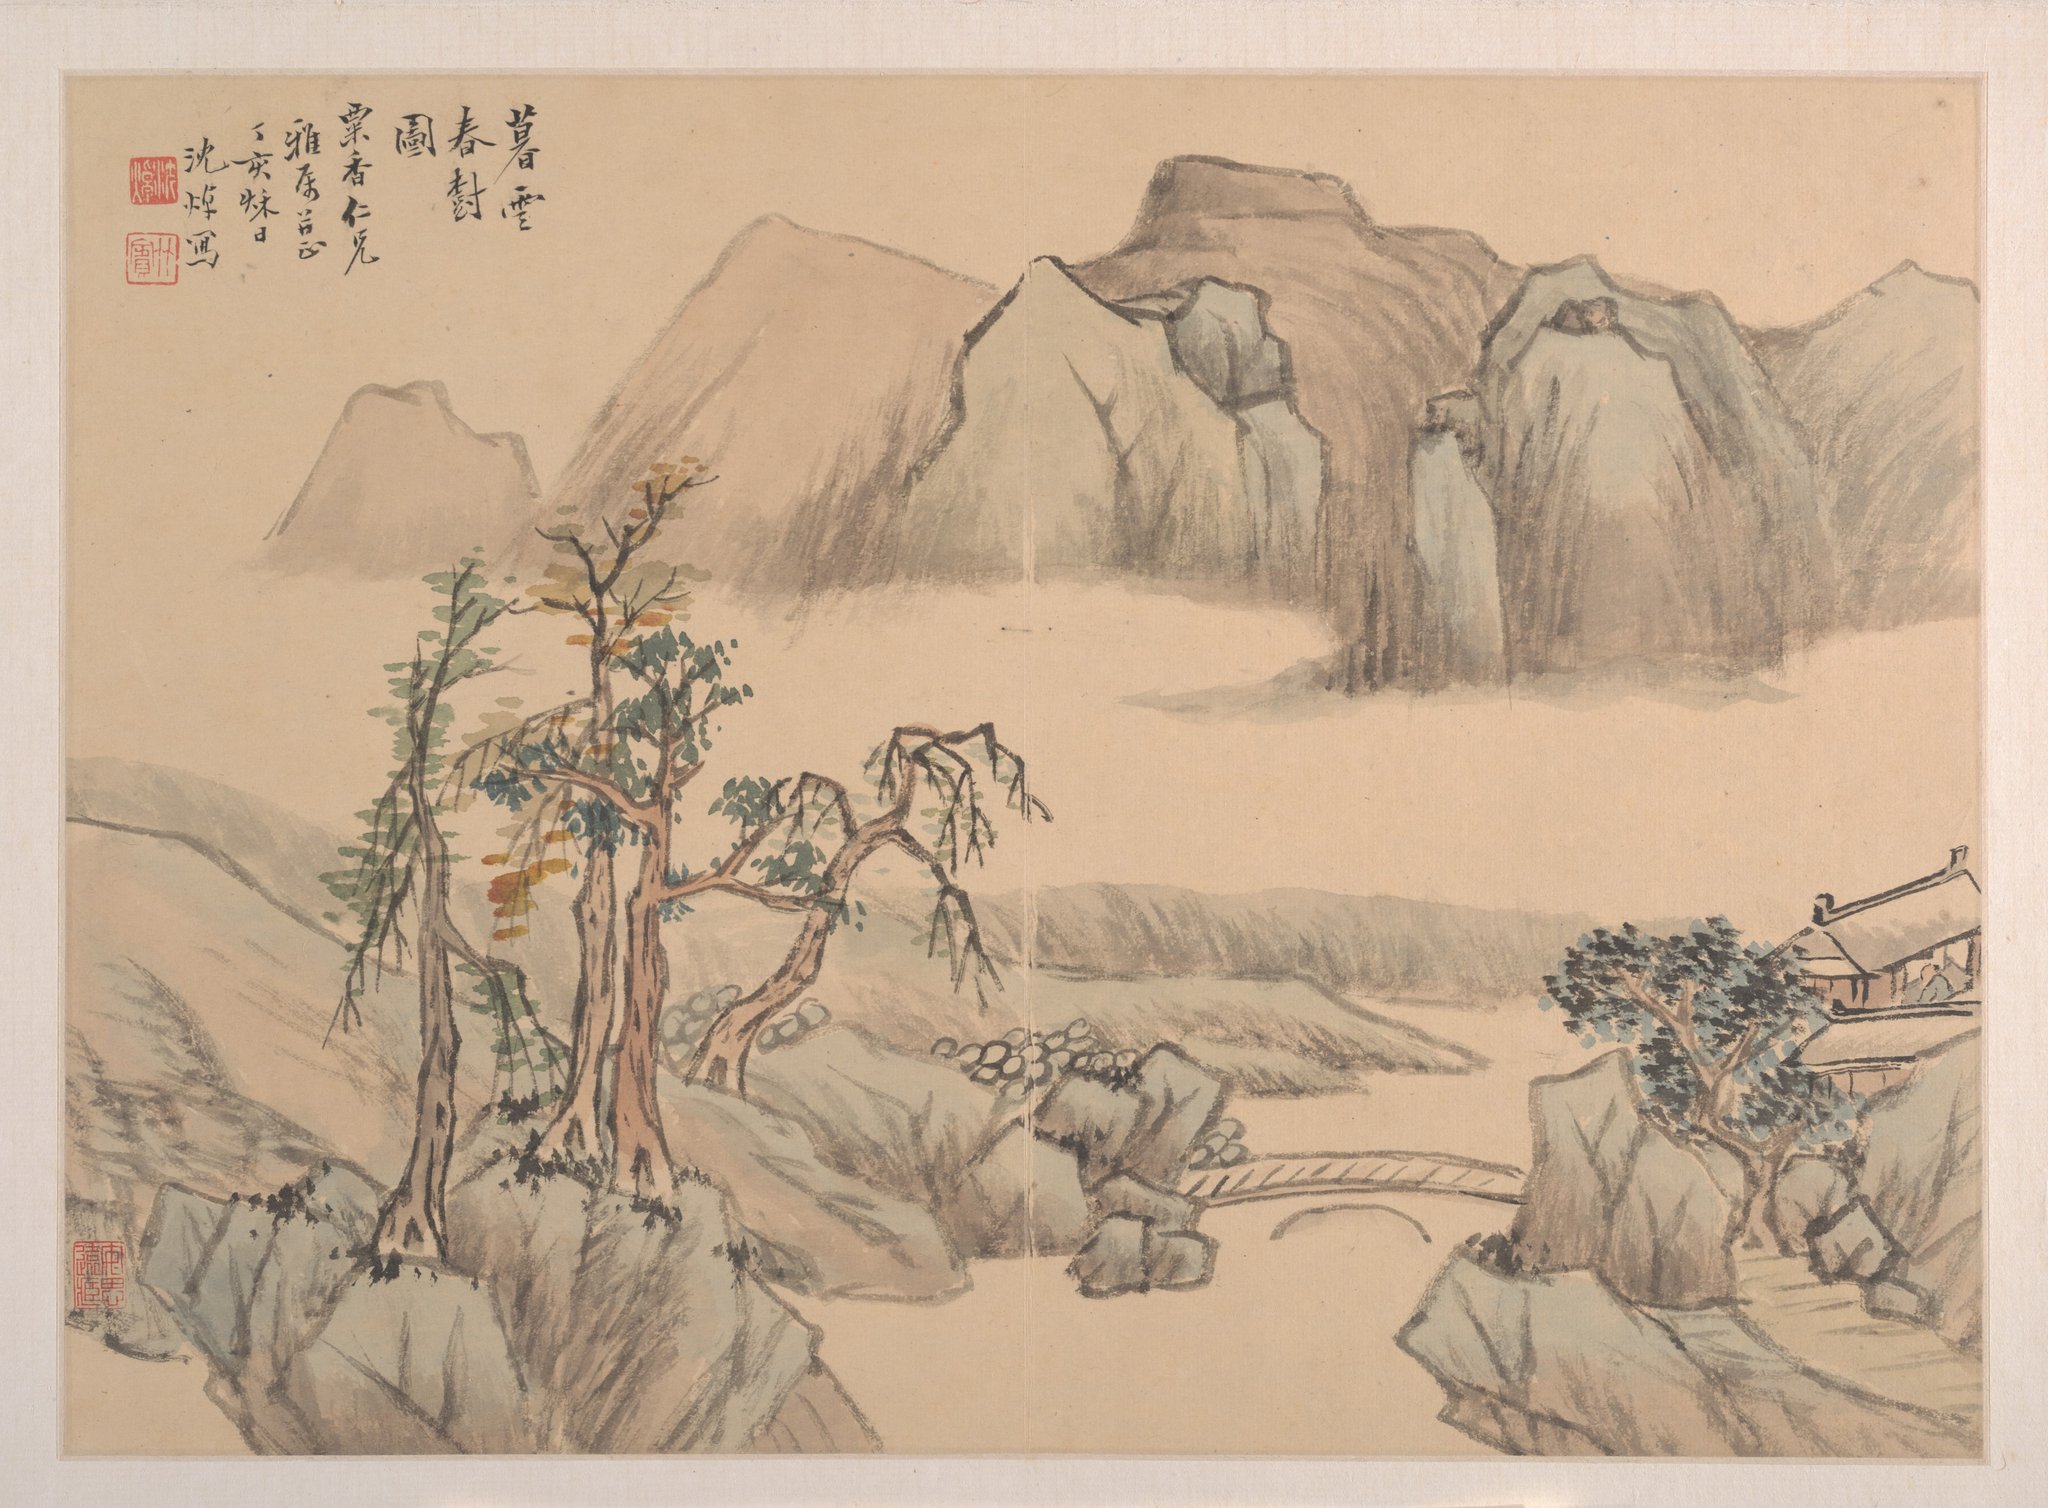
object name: album leaf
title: Landscape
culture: chinese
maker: shen zhuo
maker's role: artist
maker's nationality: chinese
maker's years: 1800-1899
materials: ink, paper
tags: mountains,landscapes